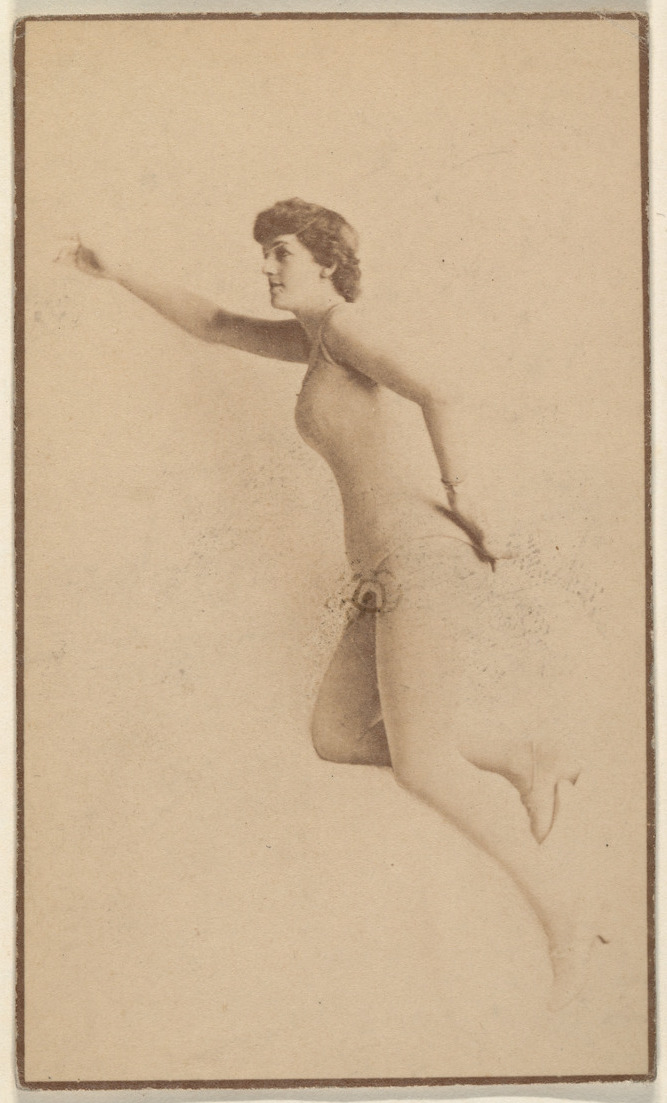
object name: photograph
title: Actress in flight, from the Actresses series (N668)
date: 1888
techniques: albumen silver print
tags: profiles,women,actresses